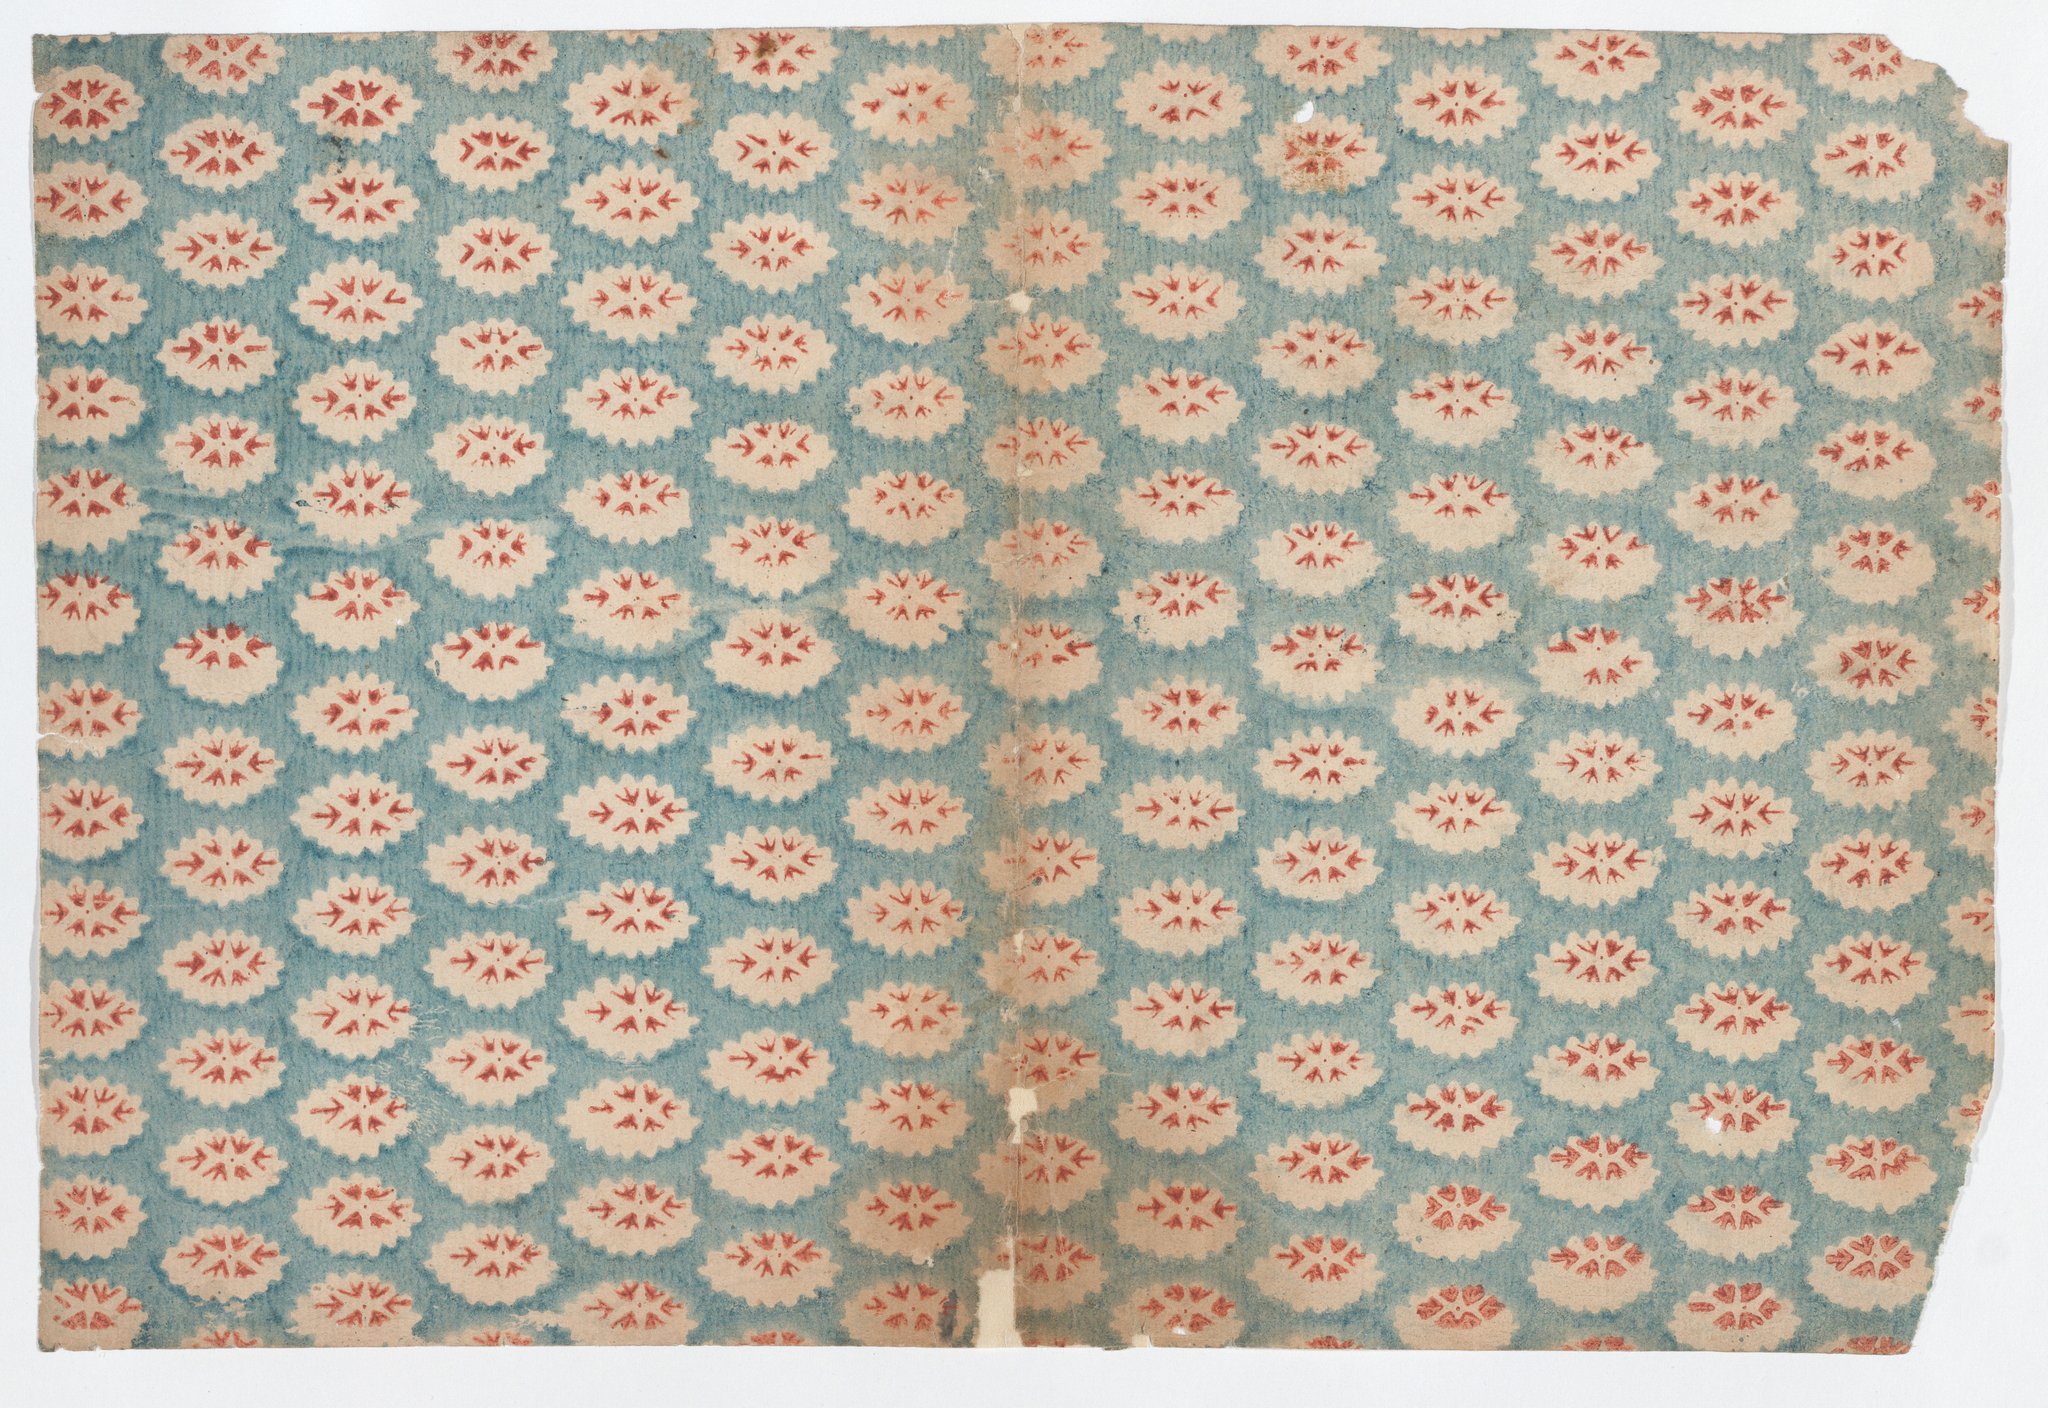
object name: print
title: Sheet with overall pattern of ovals with red designs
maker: Anonymous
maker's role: artist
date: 1801-1900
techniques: relief print